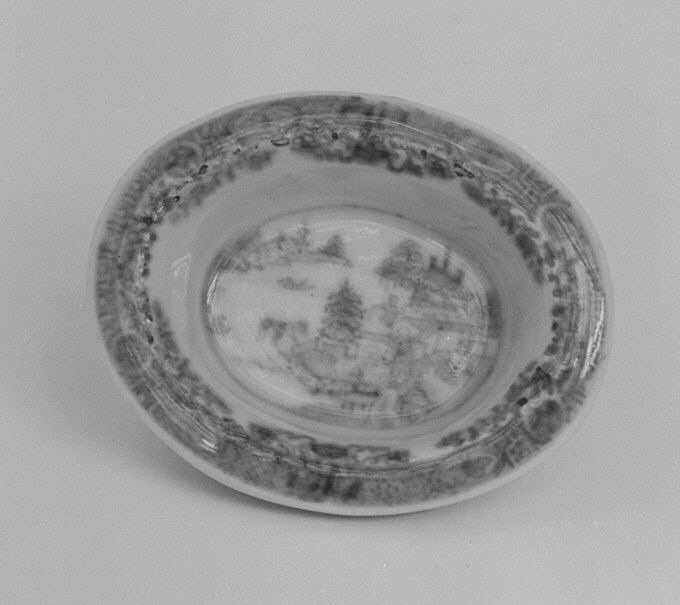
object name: salt dish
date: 1767-1833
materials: hard paste porcelain